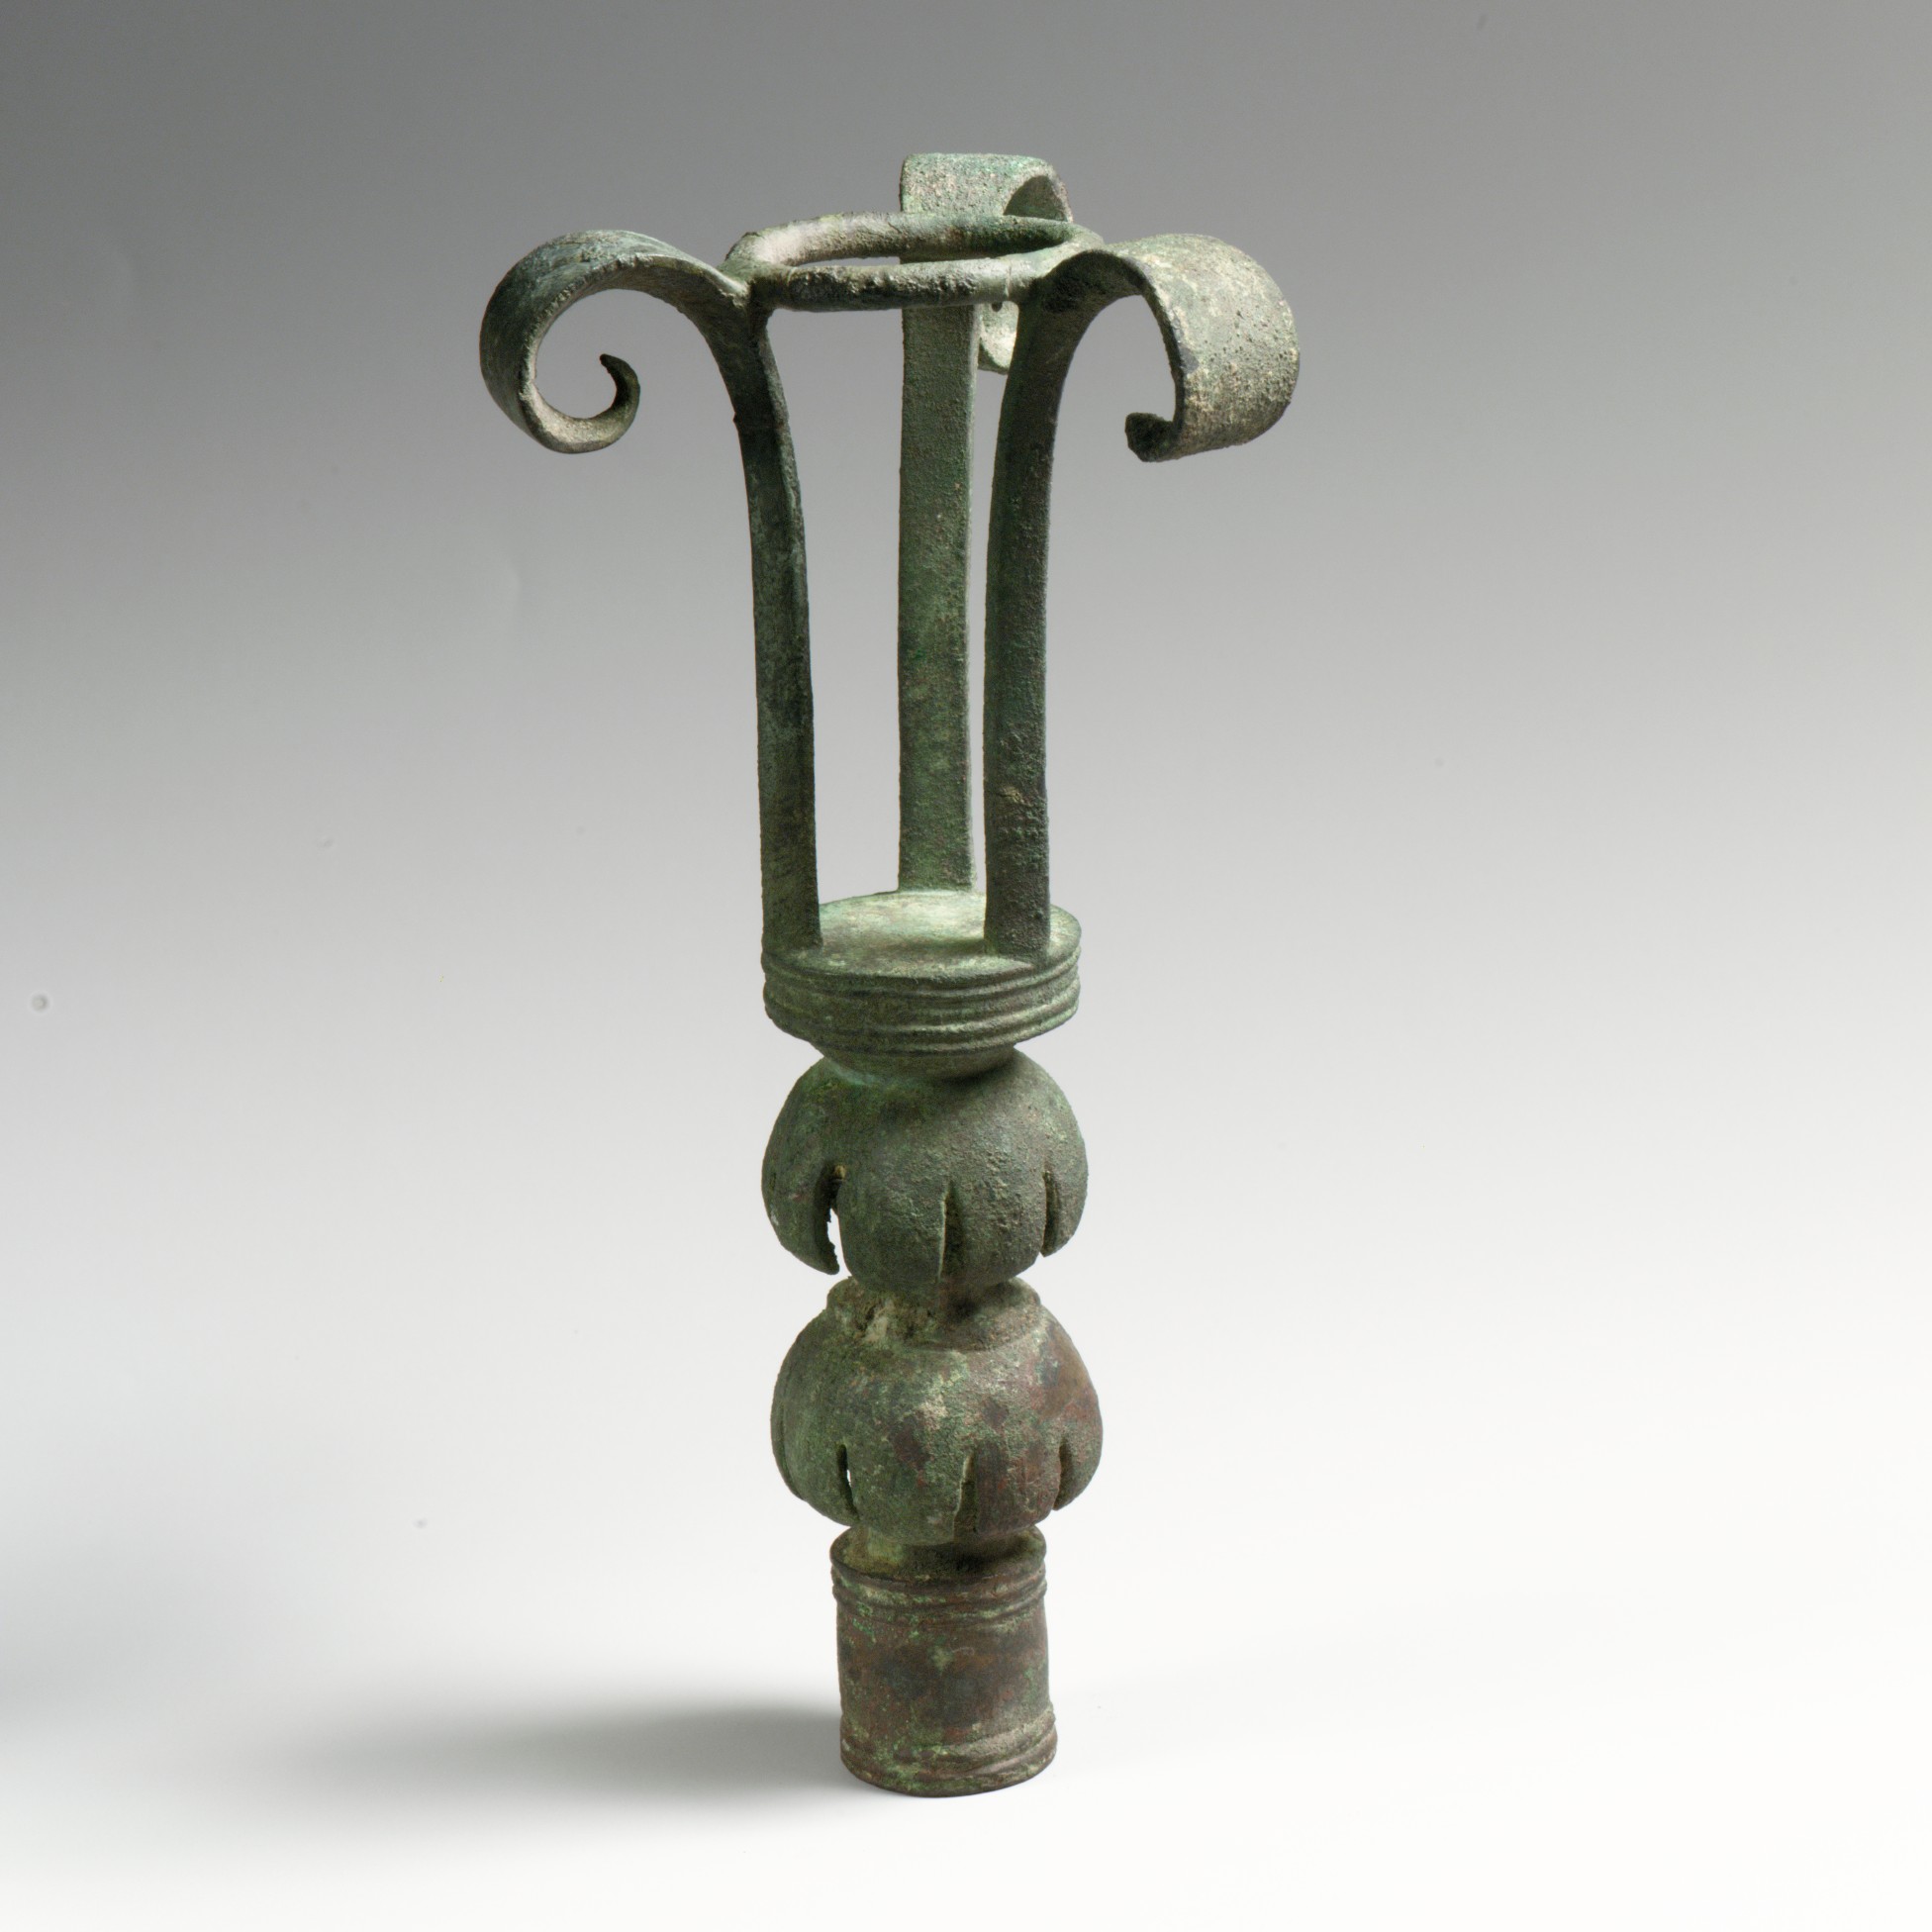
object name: lampstand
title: Bronze lampstand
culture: cypriot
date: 600-501 BCE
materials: bronze